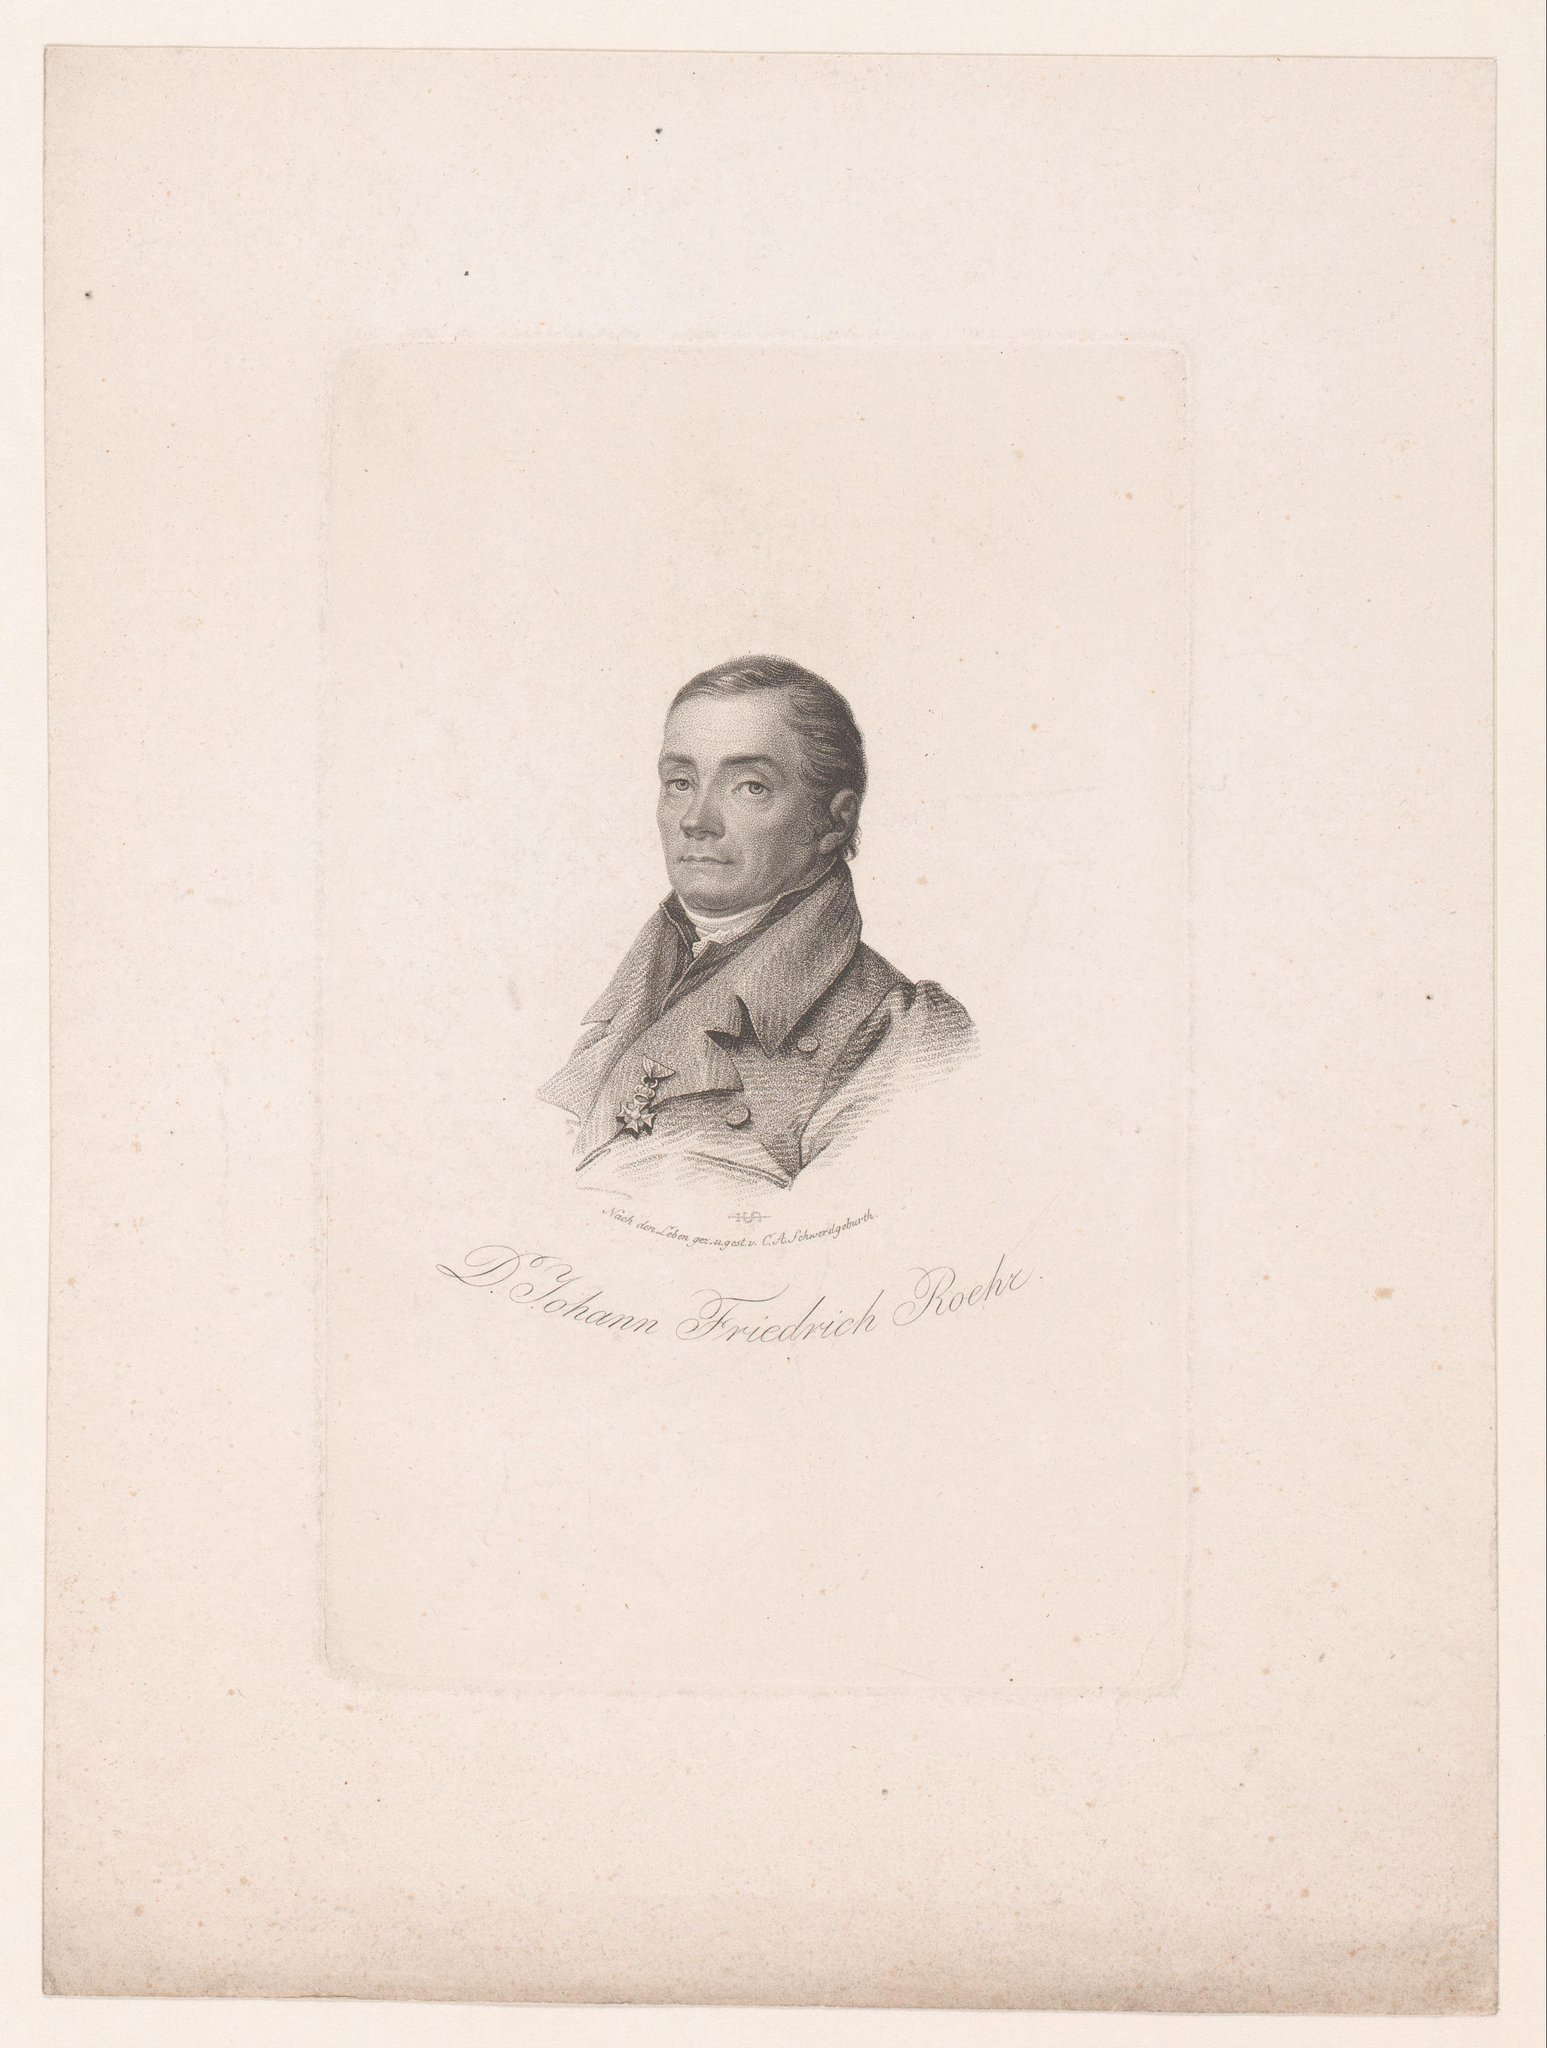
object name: print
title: Portret van Johann Friedrich Röhr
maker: carl august schwerdgeburth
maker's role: print maker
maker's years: 1785-1878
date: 1795-1878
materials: paper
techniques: engraving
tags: historical persons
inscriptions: collector's mark: Lugt 2228